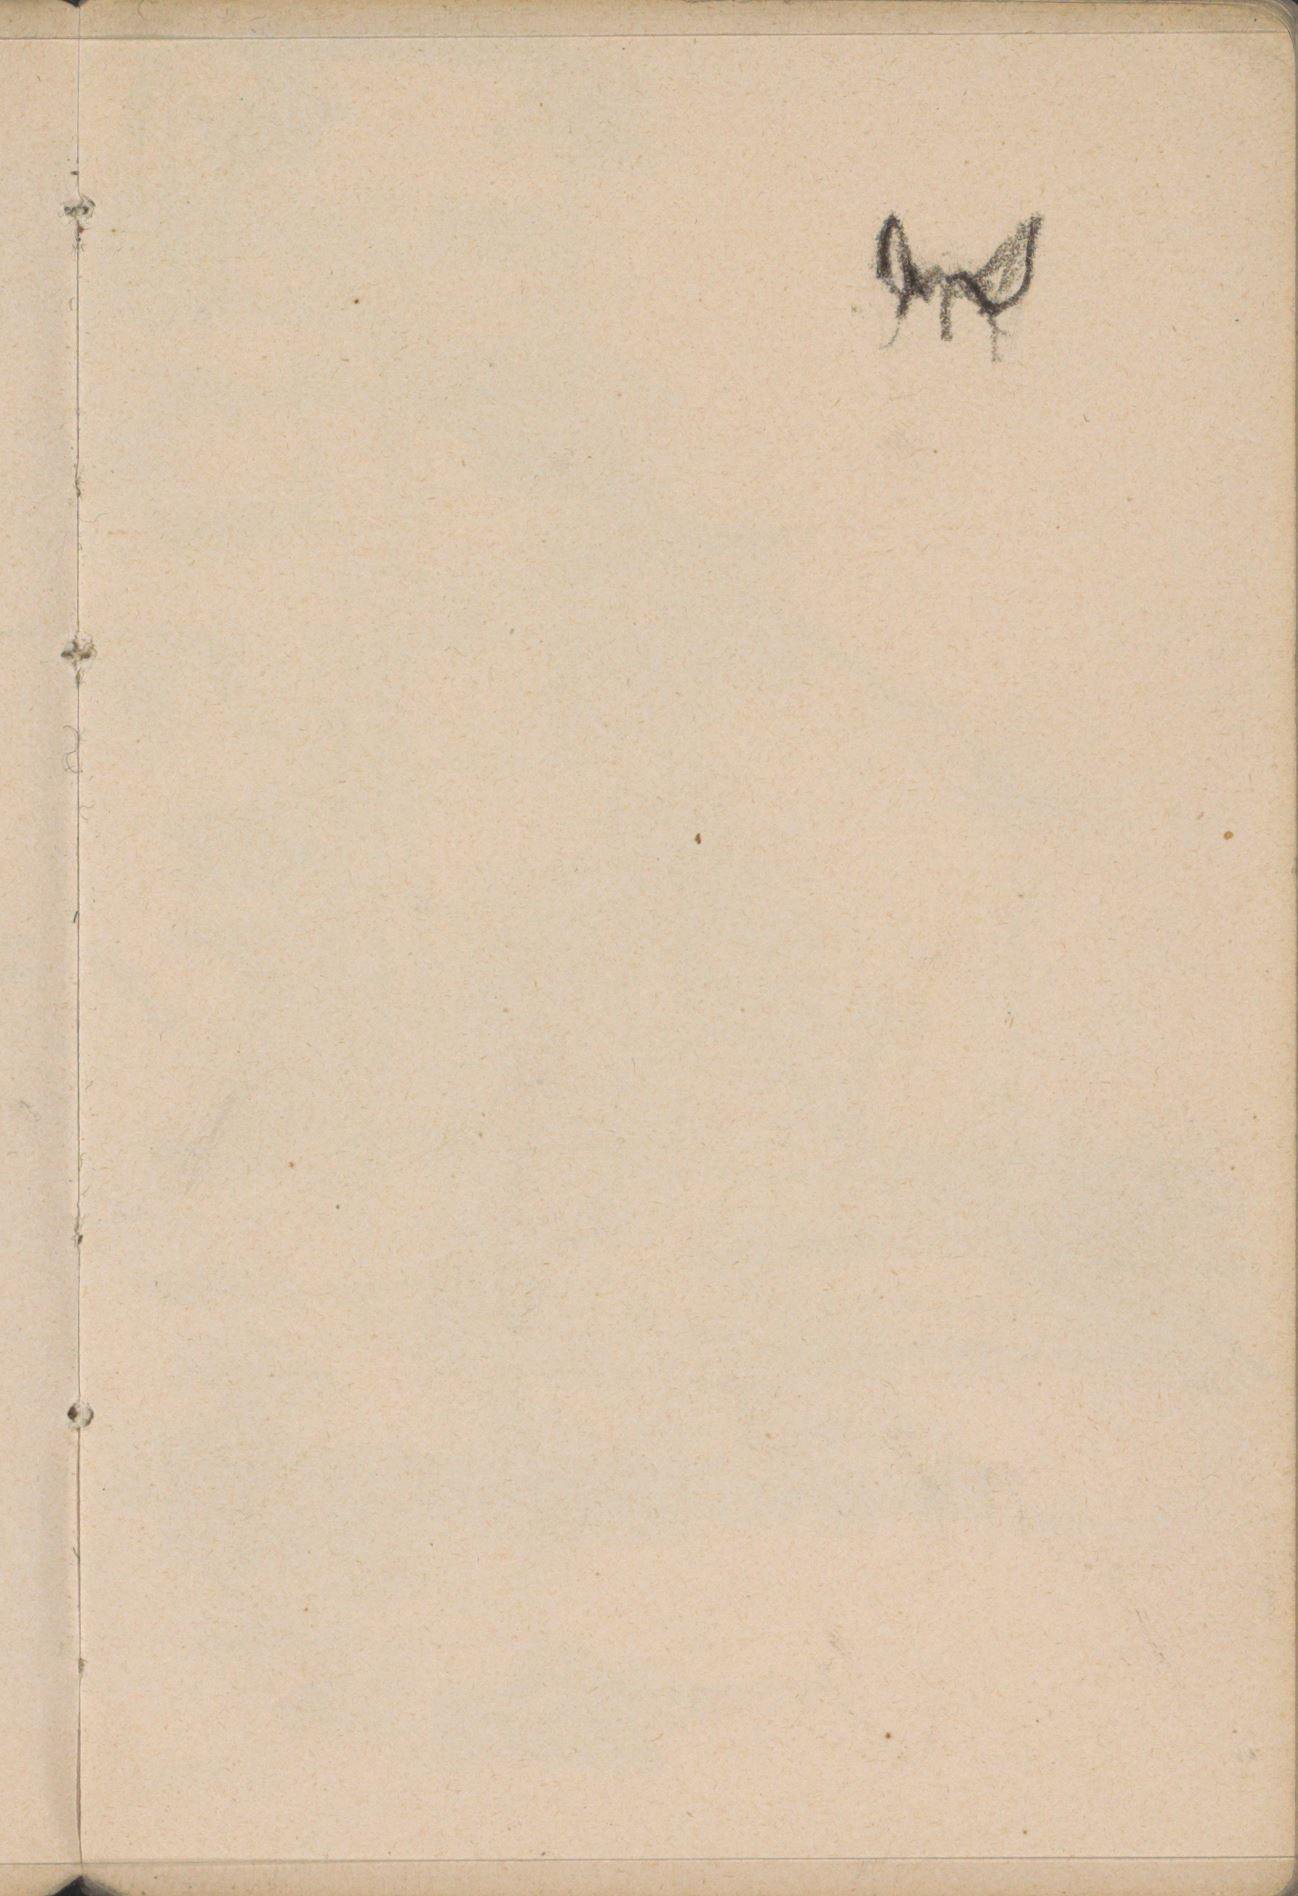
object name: sketchbook leaf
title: Studie, mogelijk van paardenoren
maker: george hendrik breitner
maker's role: draughtsman, painter, print maker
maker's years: 1857-1923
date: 1914-1923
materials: chalk, paper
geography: amsterdam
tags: horse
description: Studie, mogelijk van paardenoren. Pagina 10 uit een schetsboek met 43 bladen vervaardigd te Amsterdam.